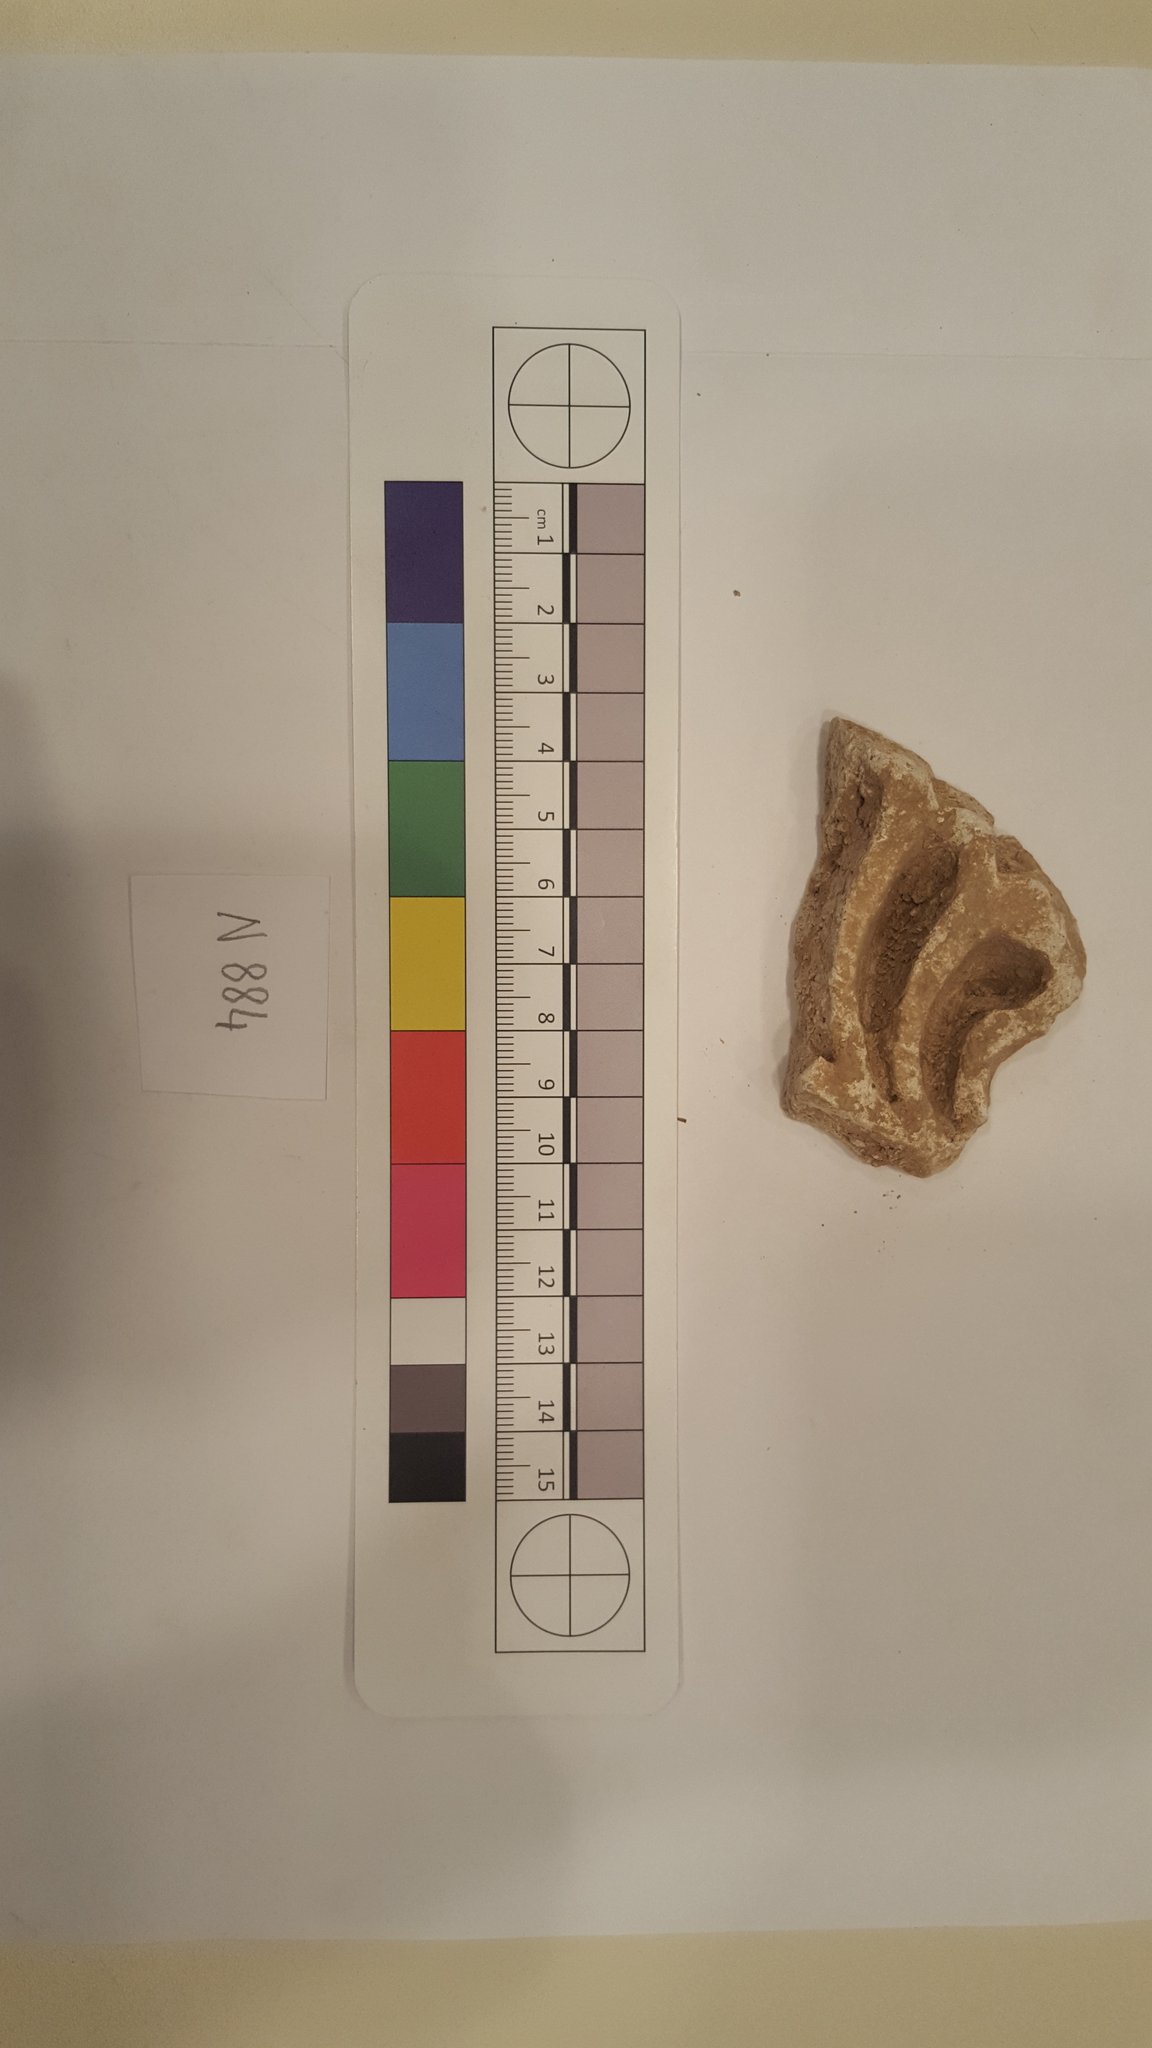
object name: fragment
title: Stucco Fragment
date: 701-1200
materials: plaster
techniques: carving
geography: iran